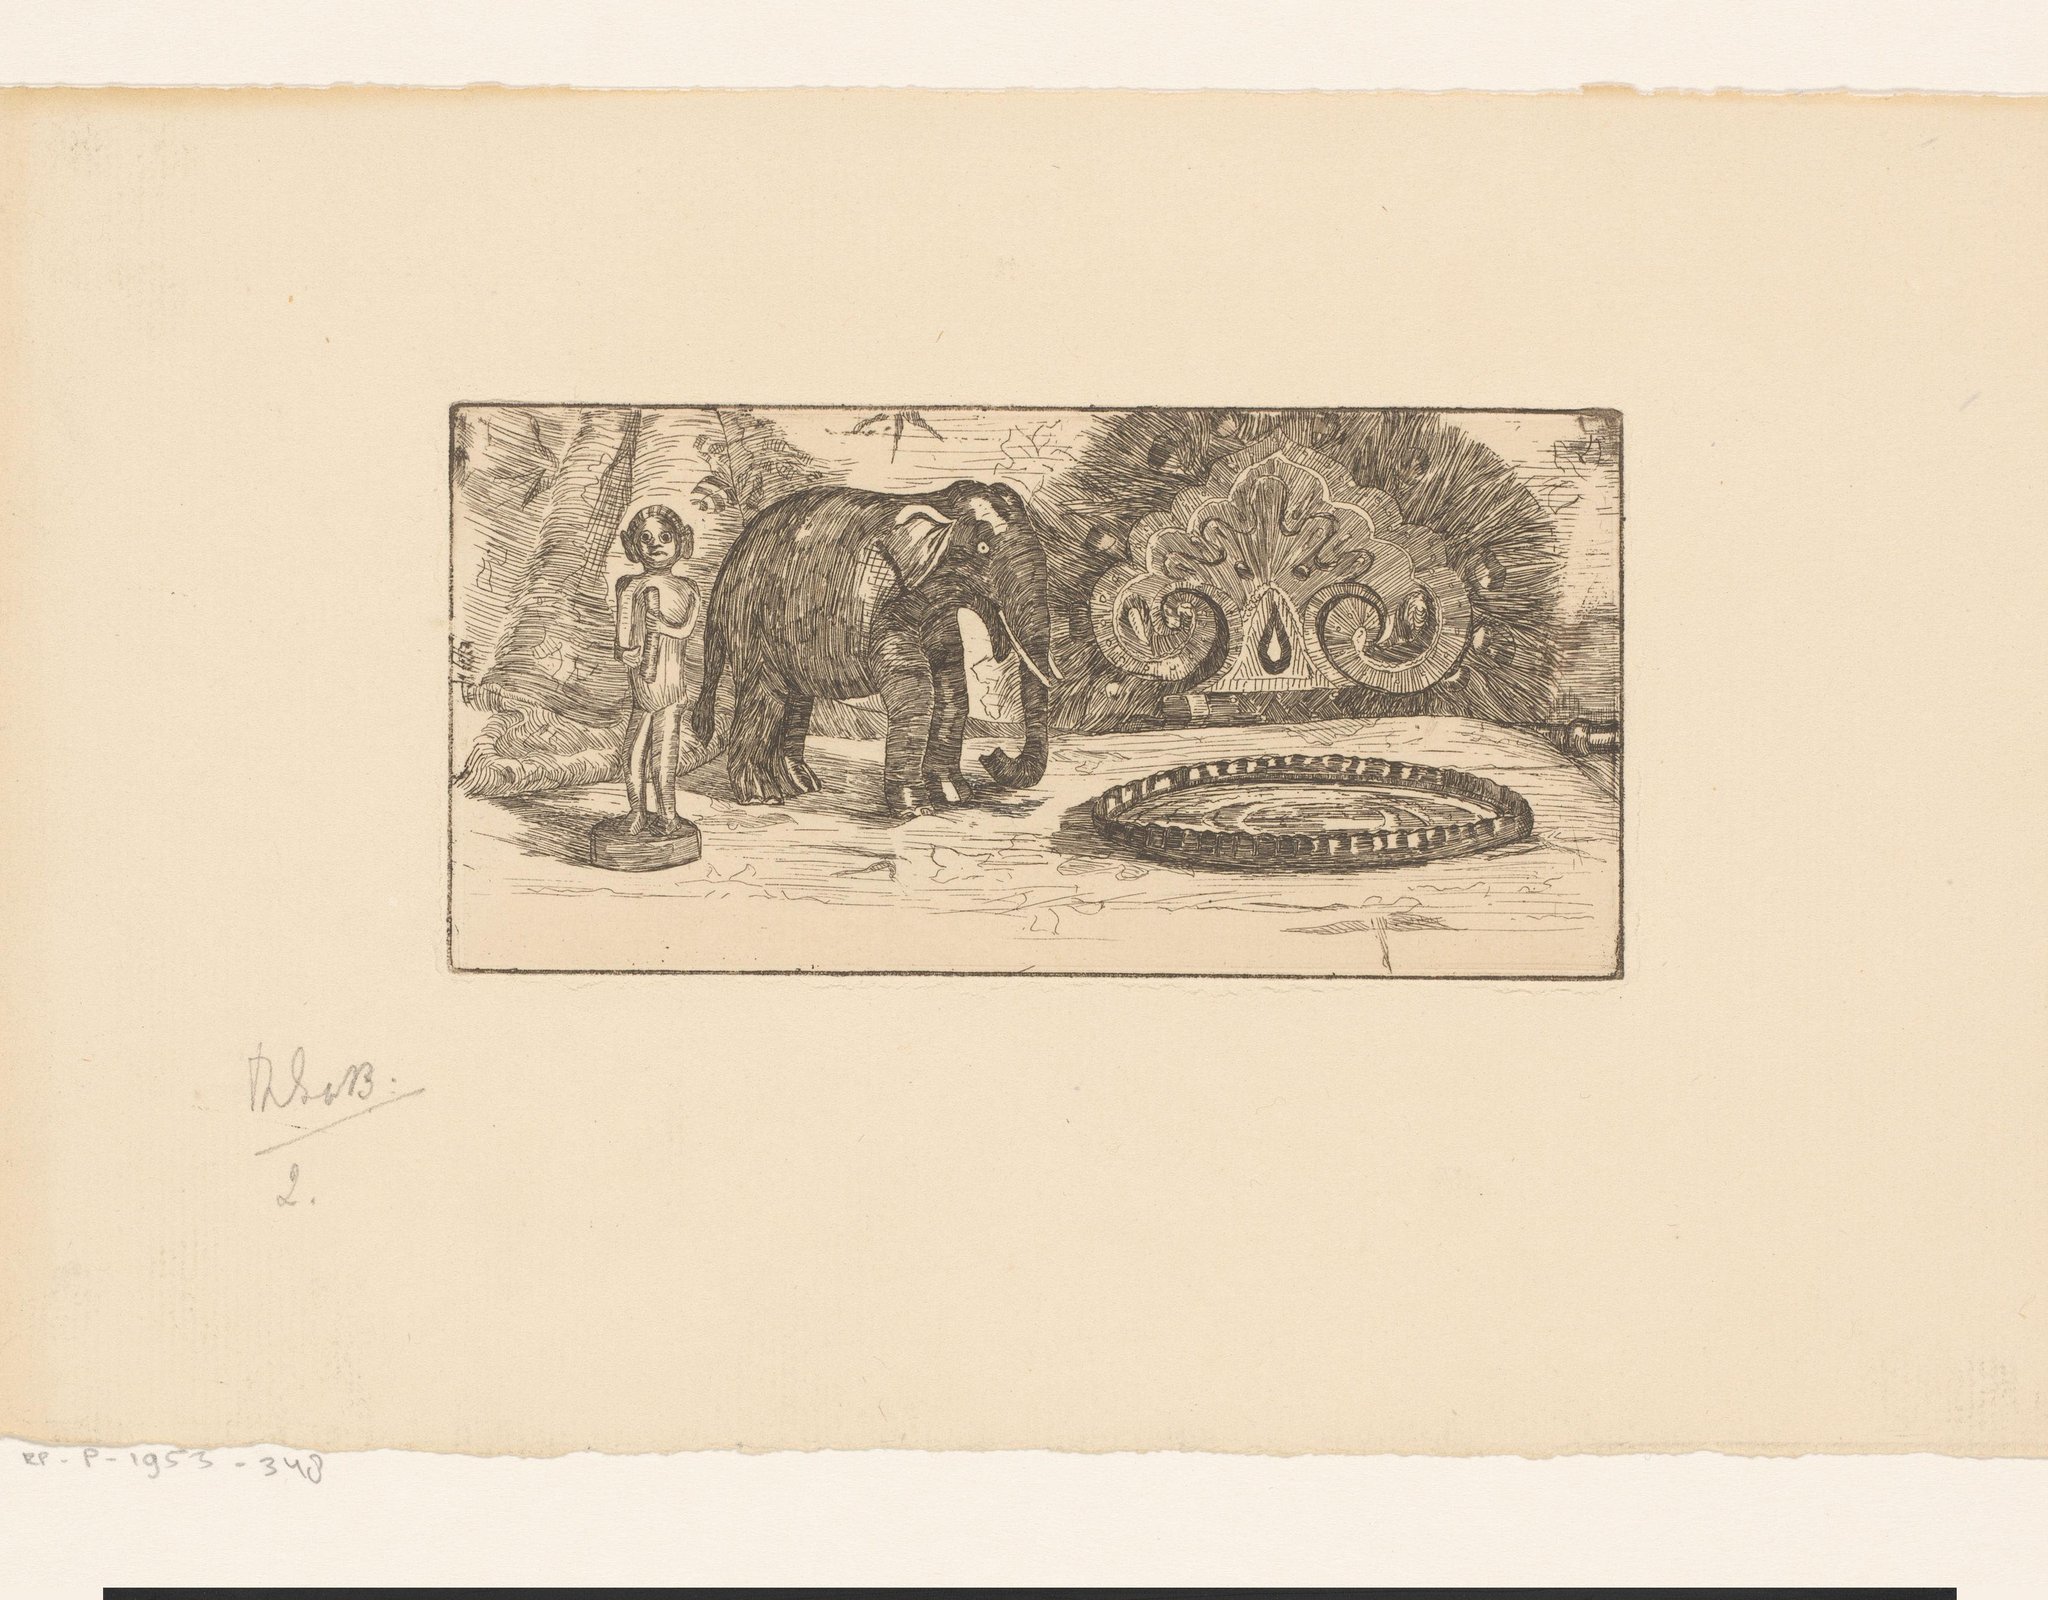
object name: print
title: Stilleven met twee beelden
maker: theodora jacoba van bosse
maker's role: print maker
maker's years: 1874-1953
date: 1899-1953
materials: paper, ink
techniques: etching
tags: monument, statue, still life of miscellaneous objects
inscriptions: number: ‘2.’, collector's mark: Lugt 2228, monogram: ‘ThJvB’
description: Stilleven met een beeld van een olifant en van een Afrikaans figuur, rechts een schaal.